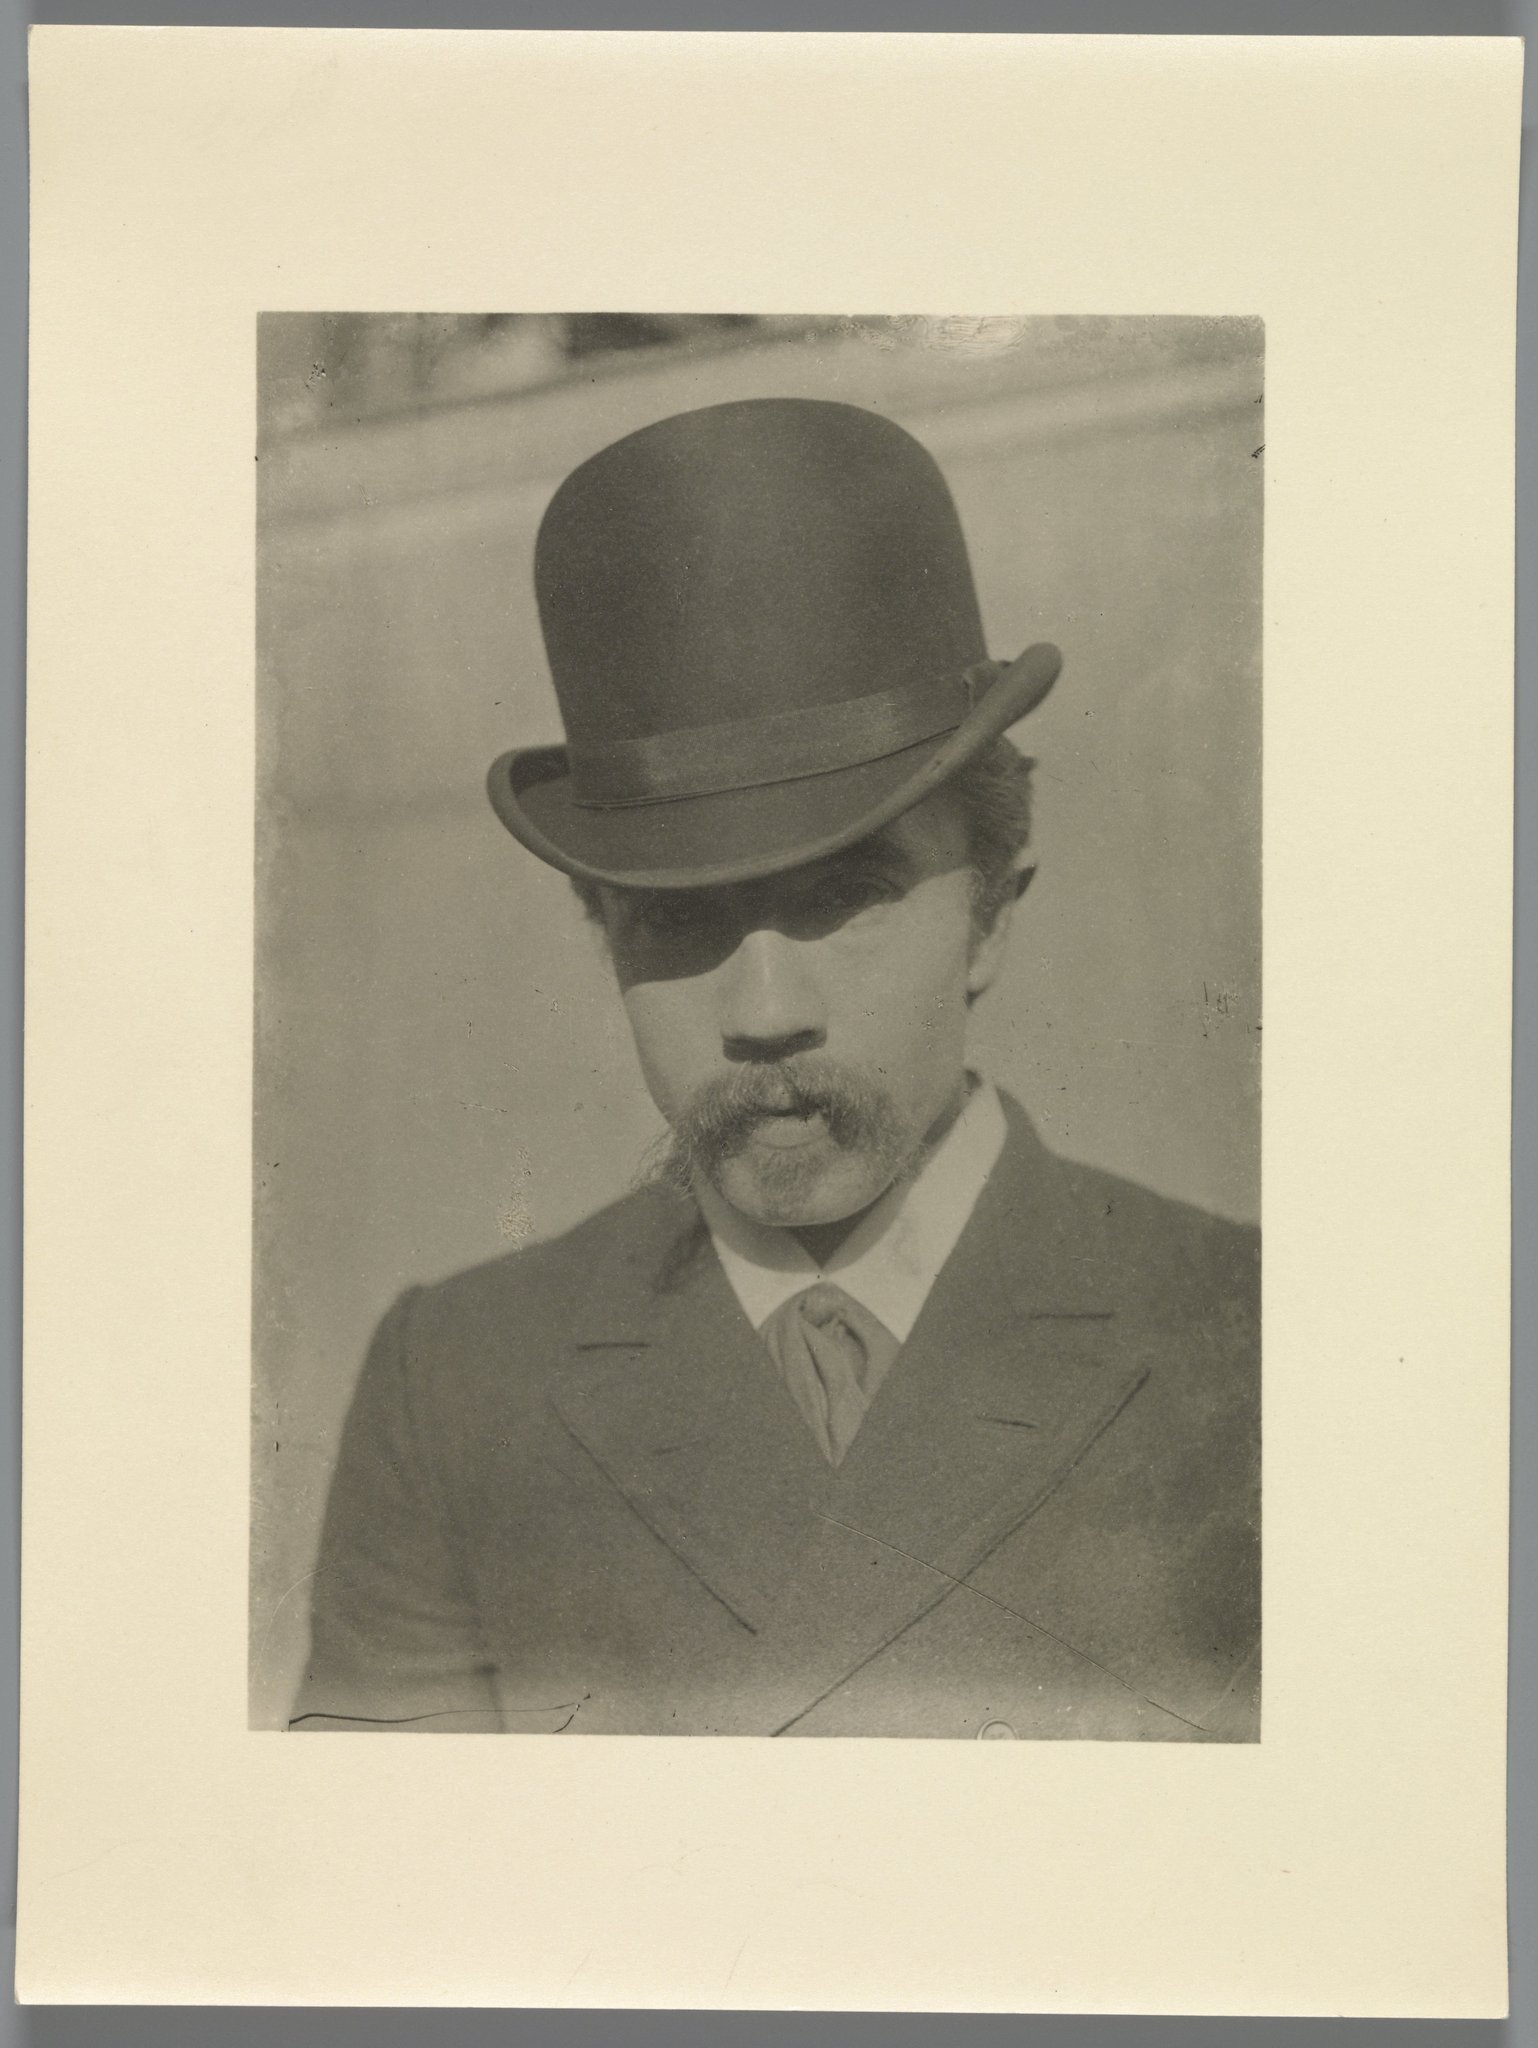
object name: photograph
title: Reproductie naar een foto van Willem Witsen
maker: Anonymous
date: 1860-1915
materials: paper, photographic support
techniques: gelatin silver print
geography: netherlands